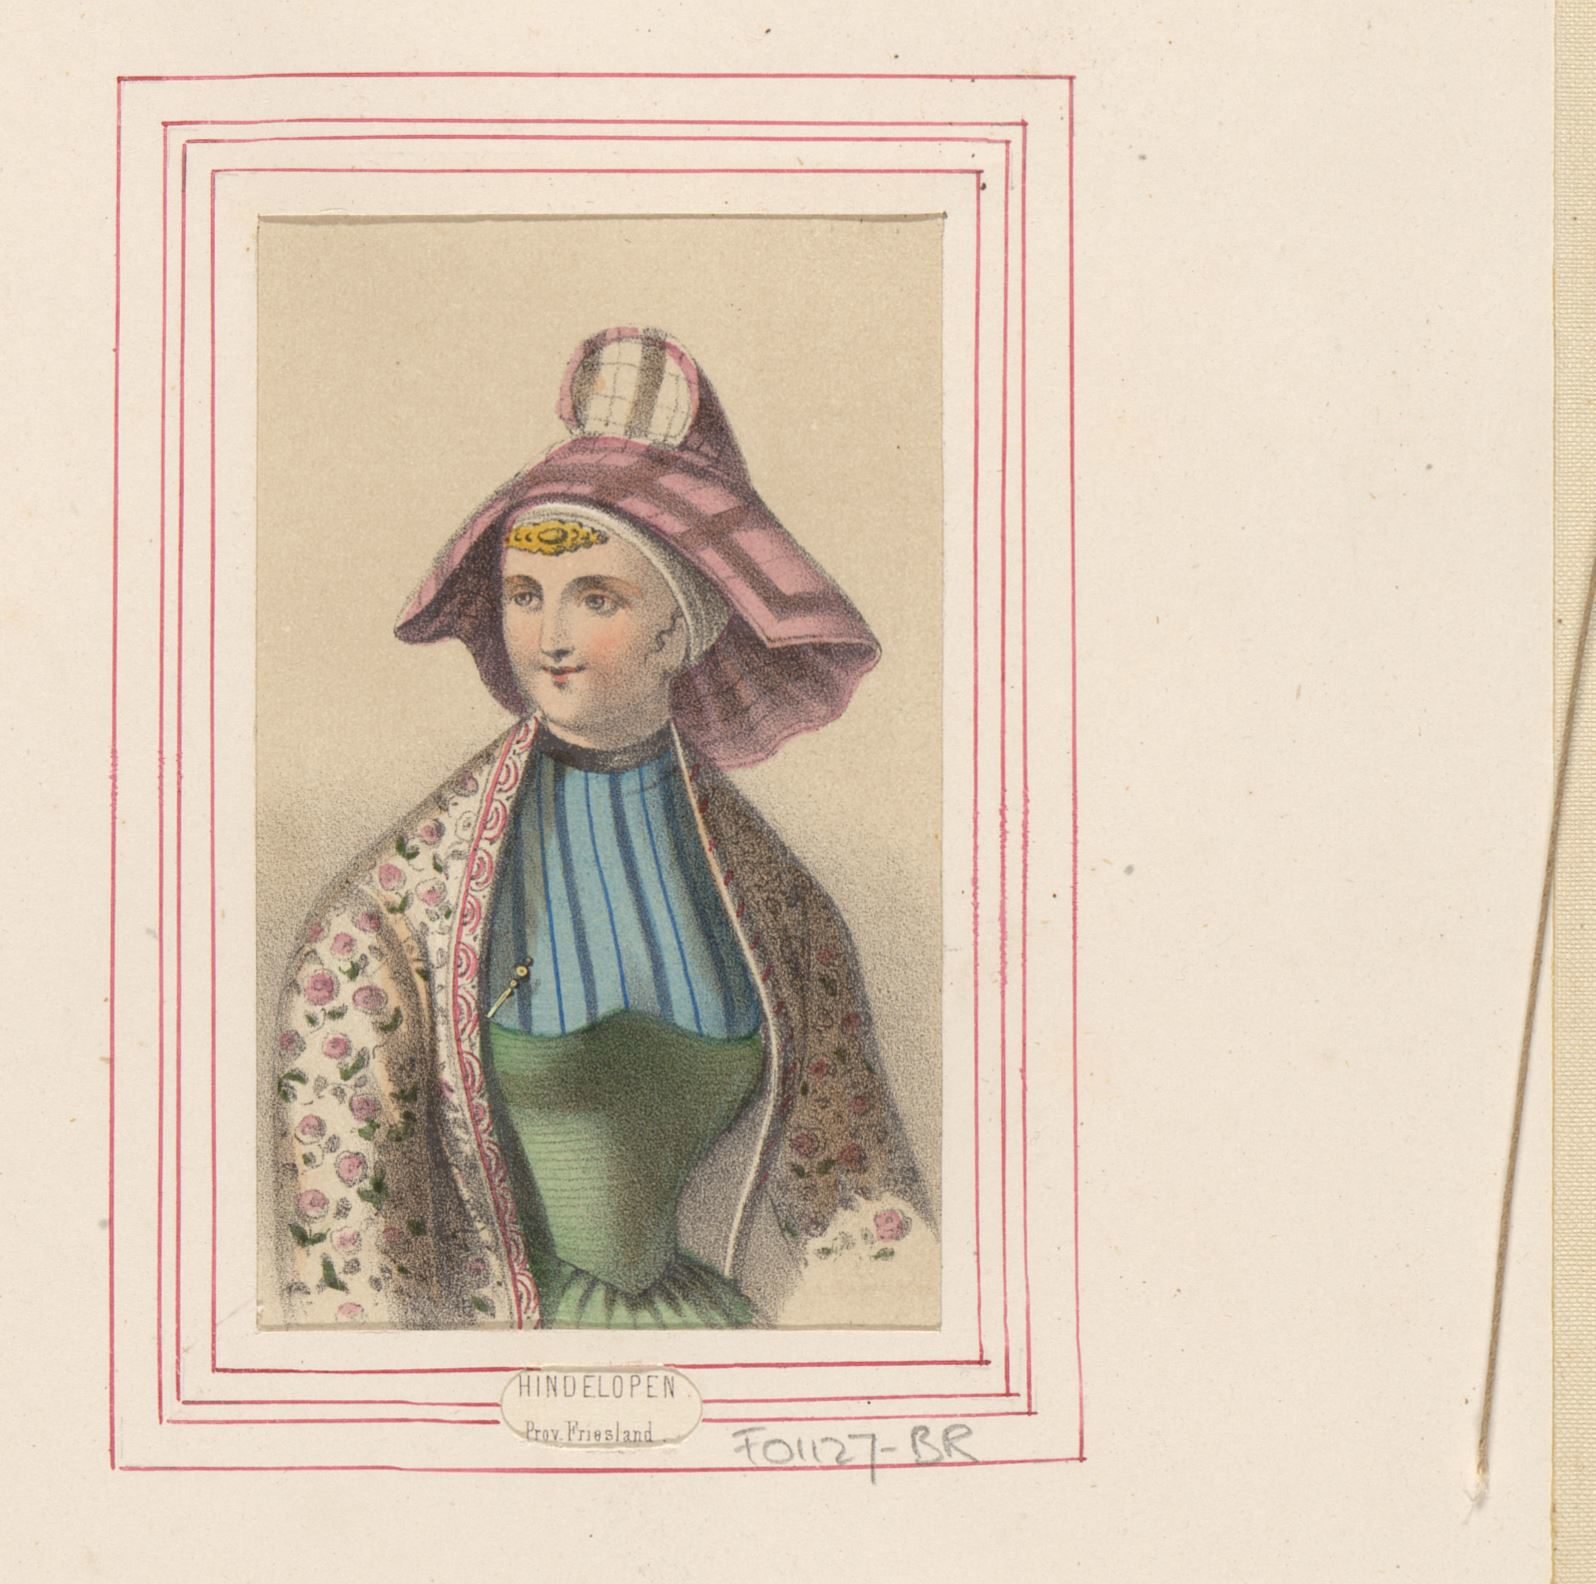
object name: print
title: Hindelopen Prov Friesland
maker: Anonymous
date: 1865-1875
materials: paper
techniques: lithograph, hand coloring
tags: folk costume, regional costume (+ women's clothes), head-gear: cap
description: Onderdeel van Album met foto's en litho's van bezienswaardigheden in Noord- en Zuid-Hollandse steden, schilderijen en klederdrachten.